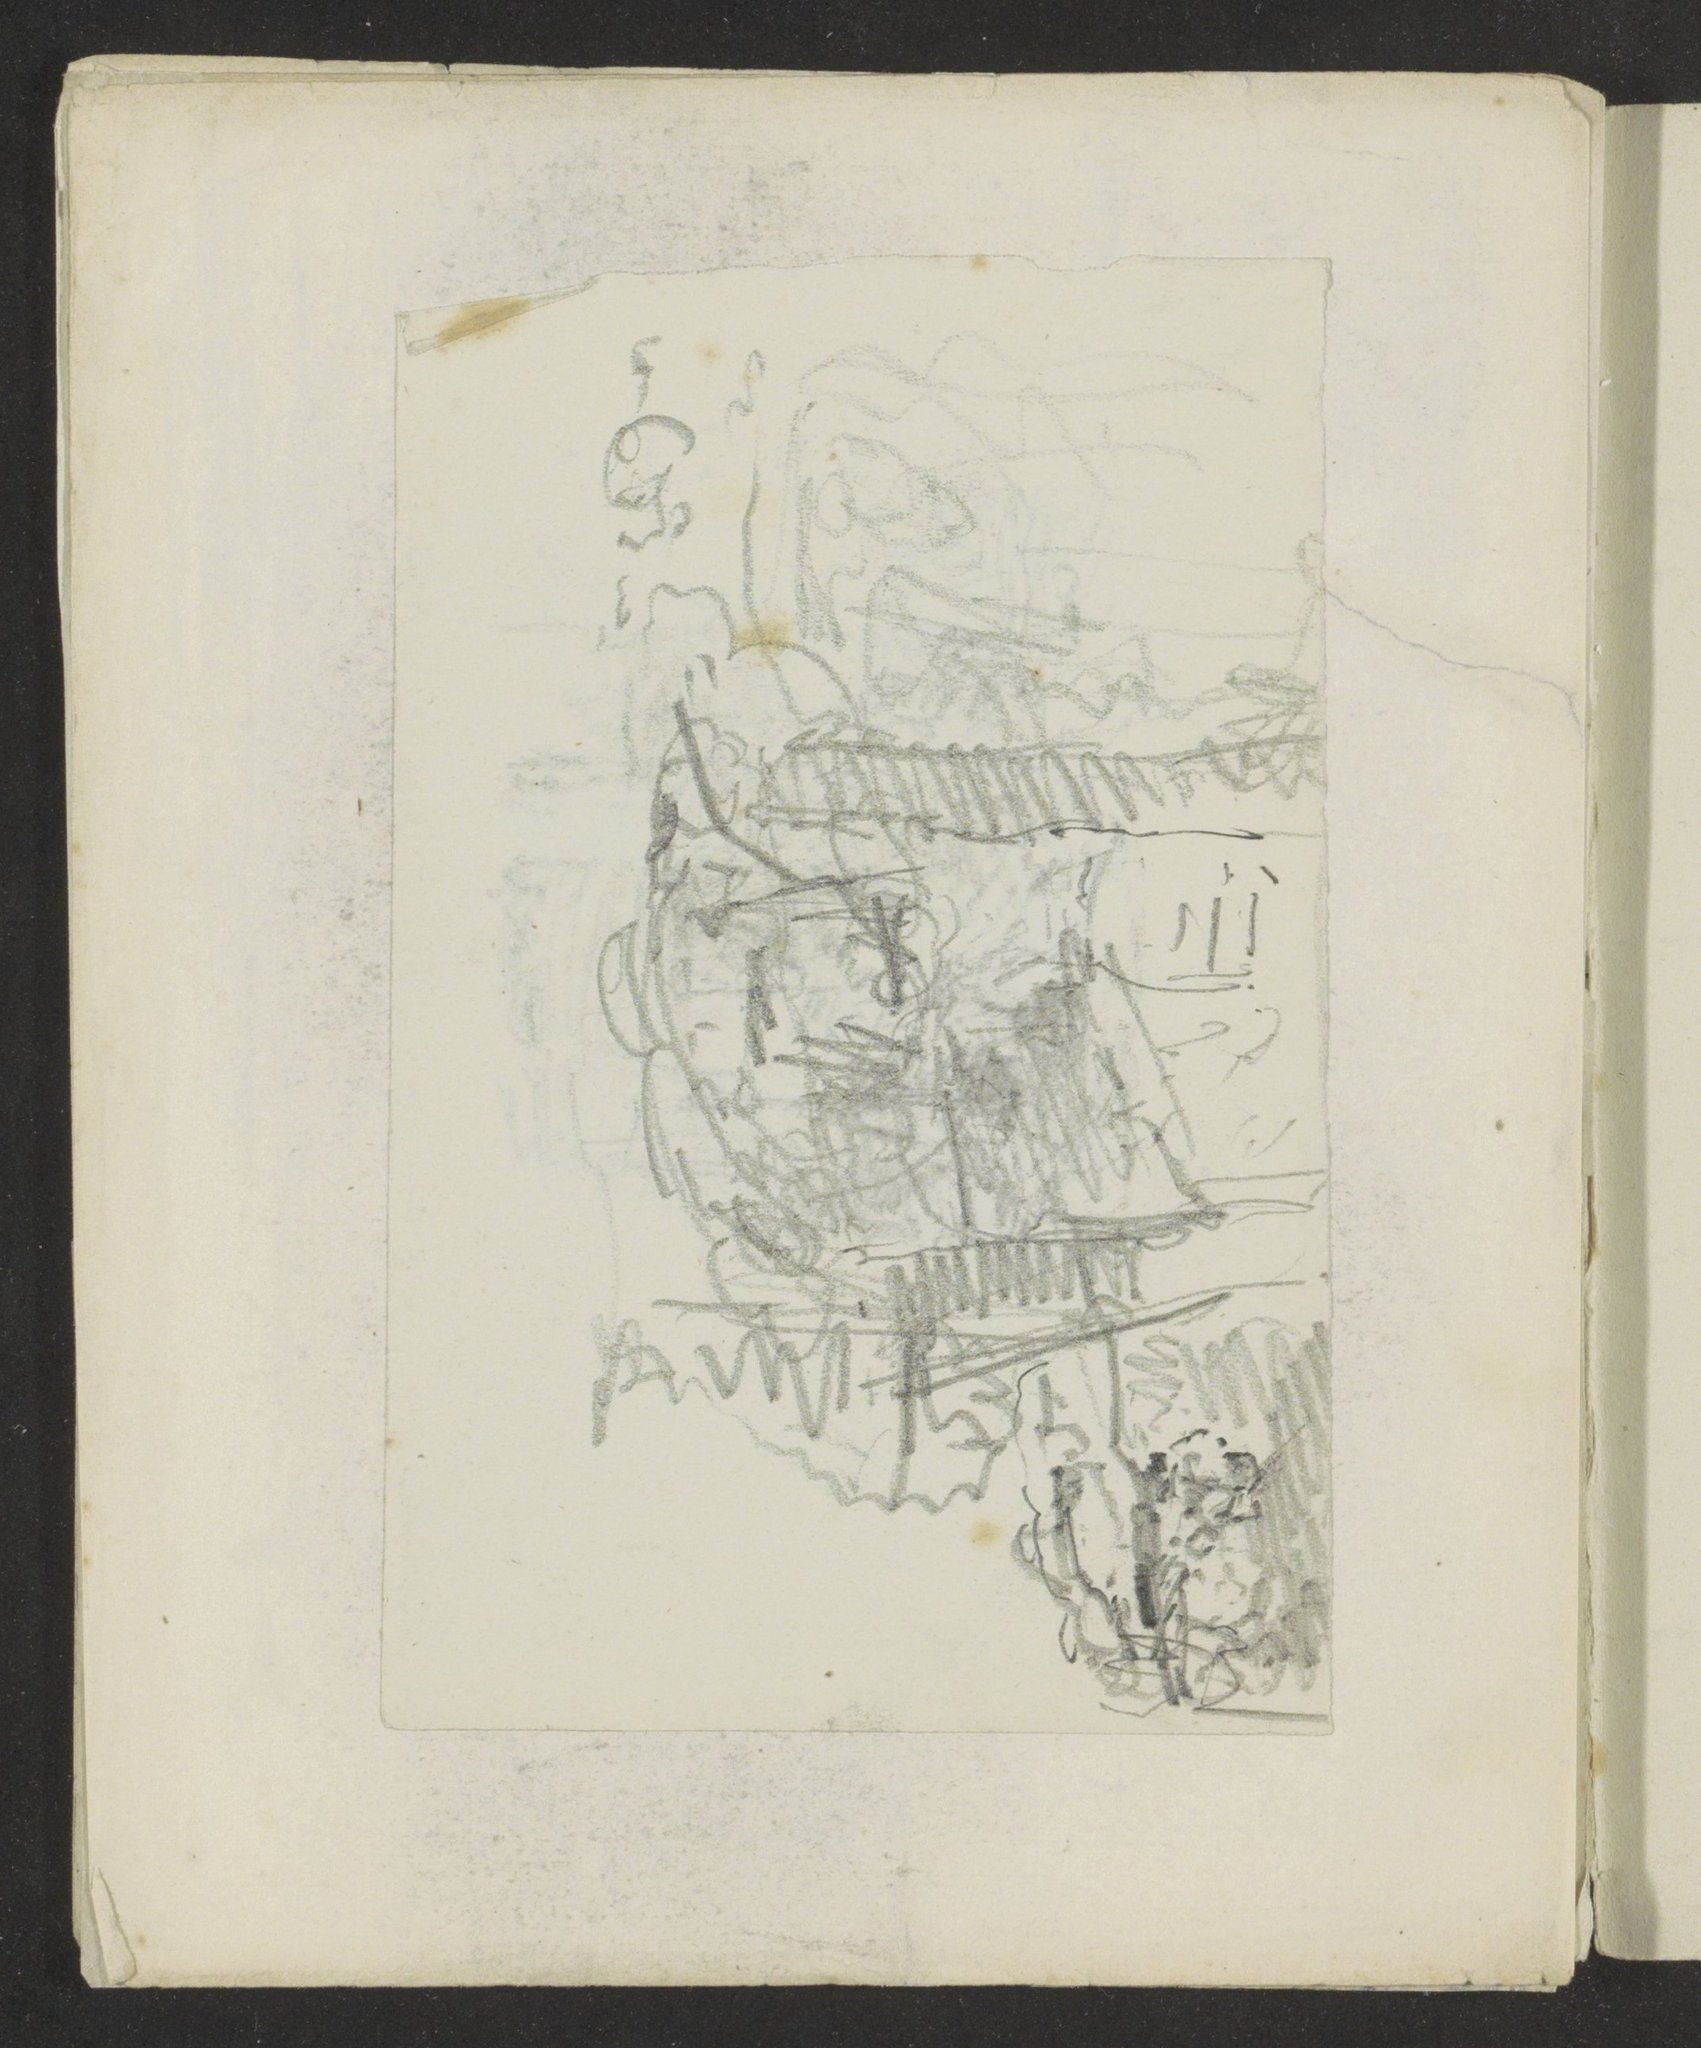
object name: sketchbook leaf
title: Studie, vermoedelijk een landschap met bomen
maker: maria vos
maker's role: draughtsman, painter, print maker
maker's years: 1824-1906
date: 1834-1906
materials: paper, pencil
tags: landscapes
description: Blad 18 verso, een los blad tussen pagina 17 en het achterste schutblad van een schetsboek met 17 bladen.